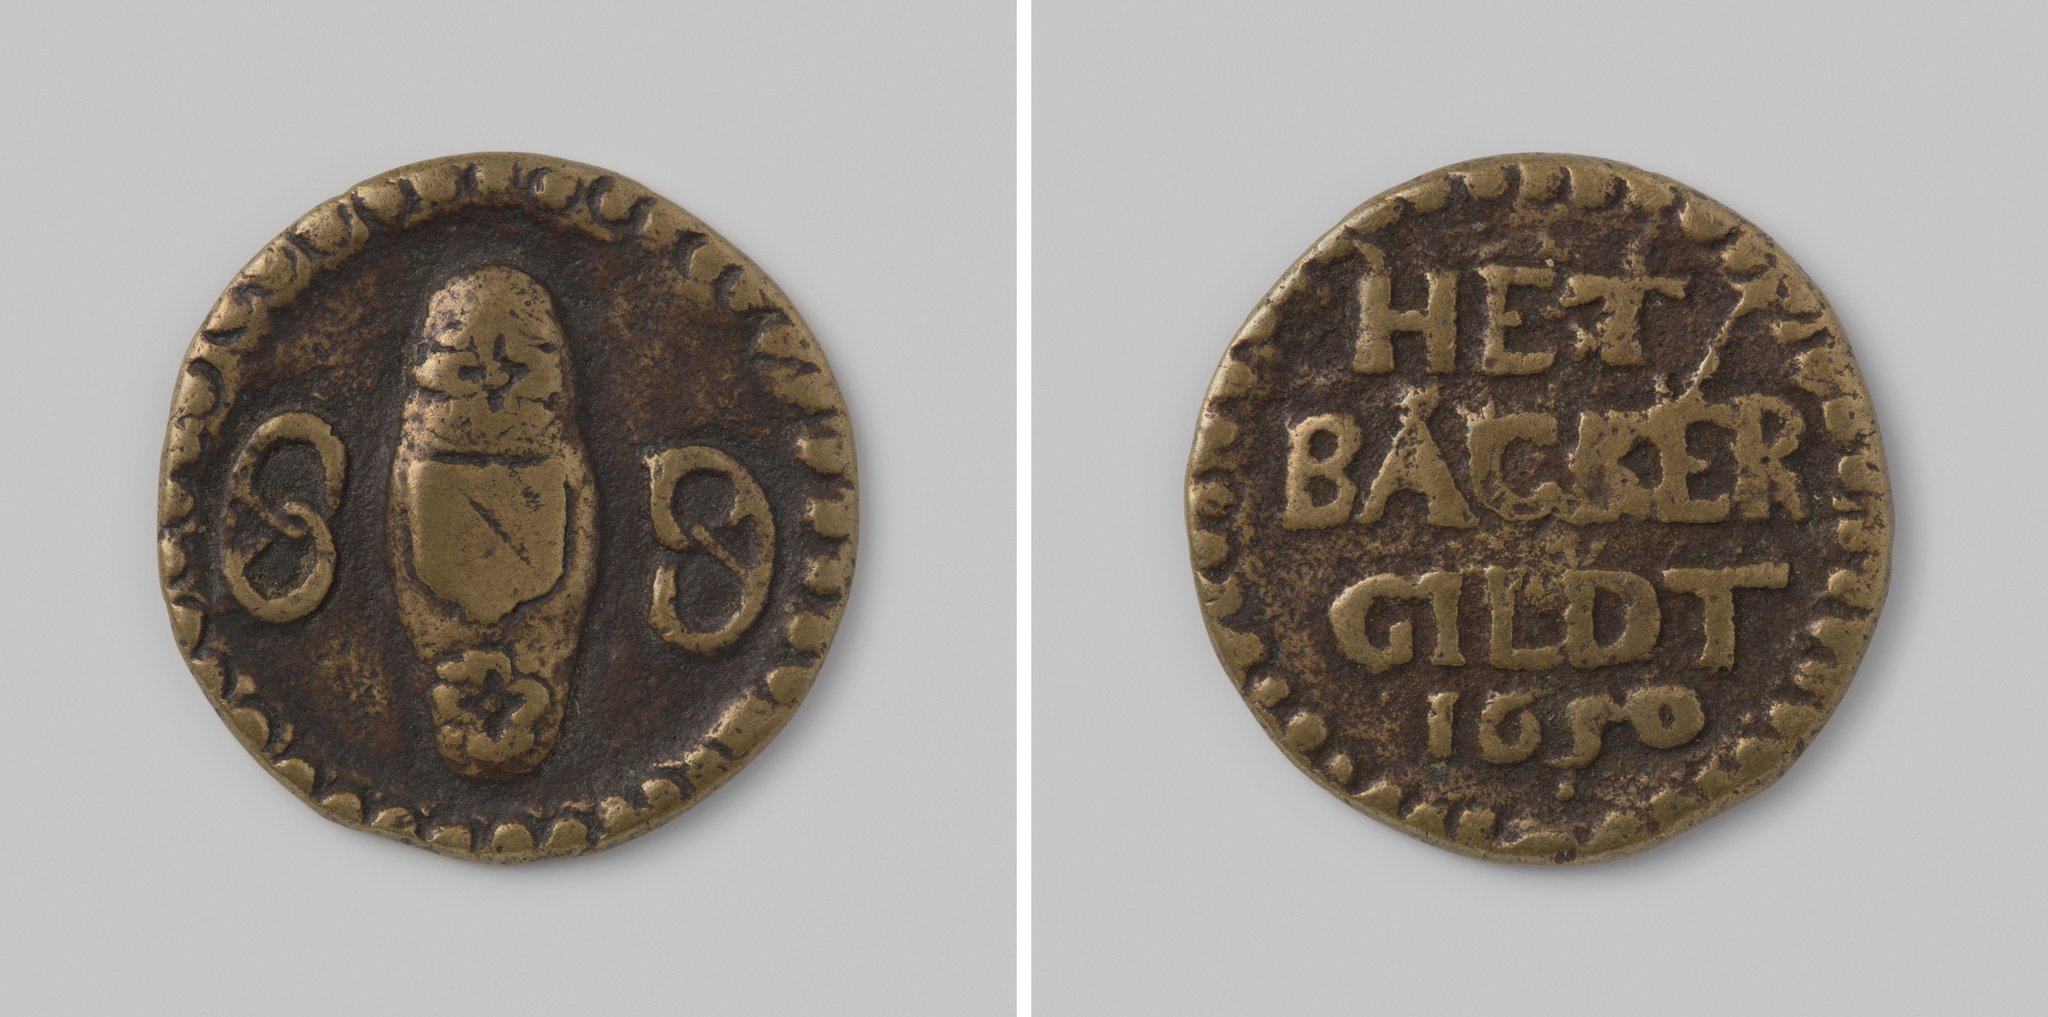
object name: history medal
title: Presentiepenning van het Bakkersgilde te Utrecht, 1650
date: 1650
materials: brass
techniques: casting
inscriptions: inscription: ‘HET / BACKER / GILDT / 1650’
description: Gegoten messing penning, op de voorzijde een brood waarop het stadswapen tussen twe krakelingen, op de keerzijdevier regels tekst